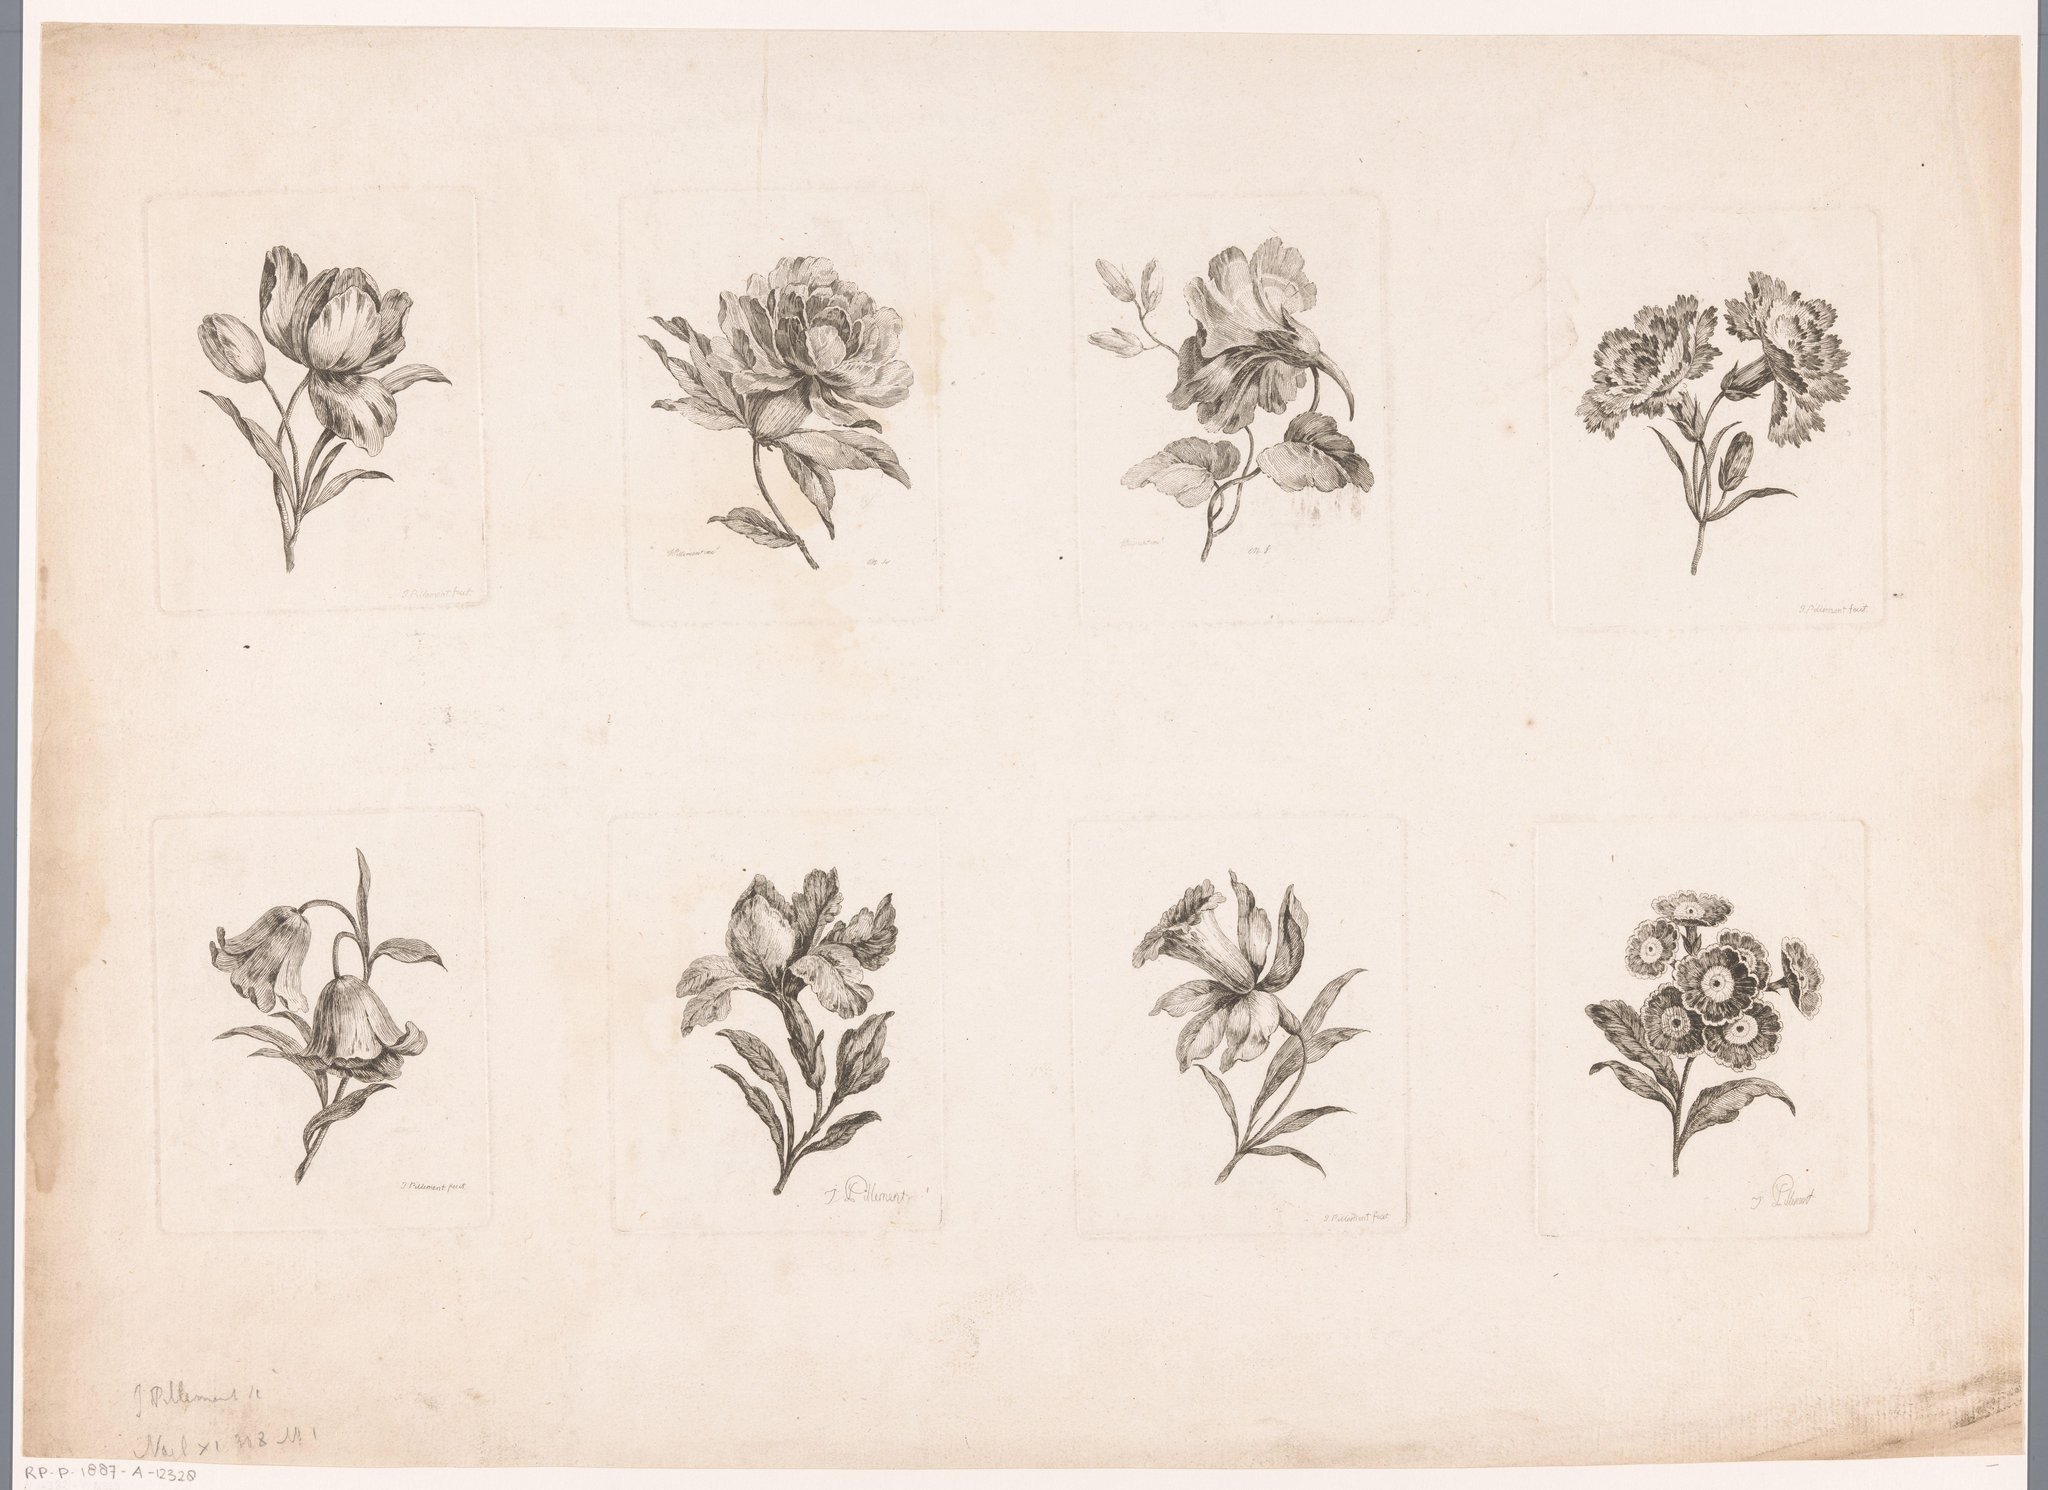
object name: print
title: Acht bloemen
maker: jean baptiste pillement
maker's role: designer, draughtsman, print maker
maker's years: 1728-1808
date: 1758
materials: paper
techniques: etching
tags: flowers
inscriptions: collector's mark: Lugt 2228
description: Acht prenten op een blad. Twee rijen van vier met verschillende bloemen waaronder diverse rozen, anjers en een trompetbloem.